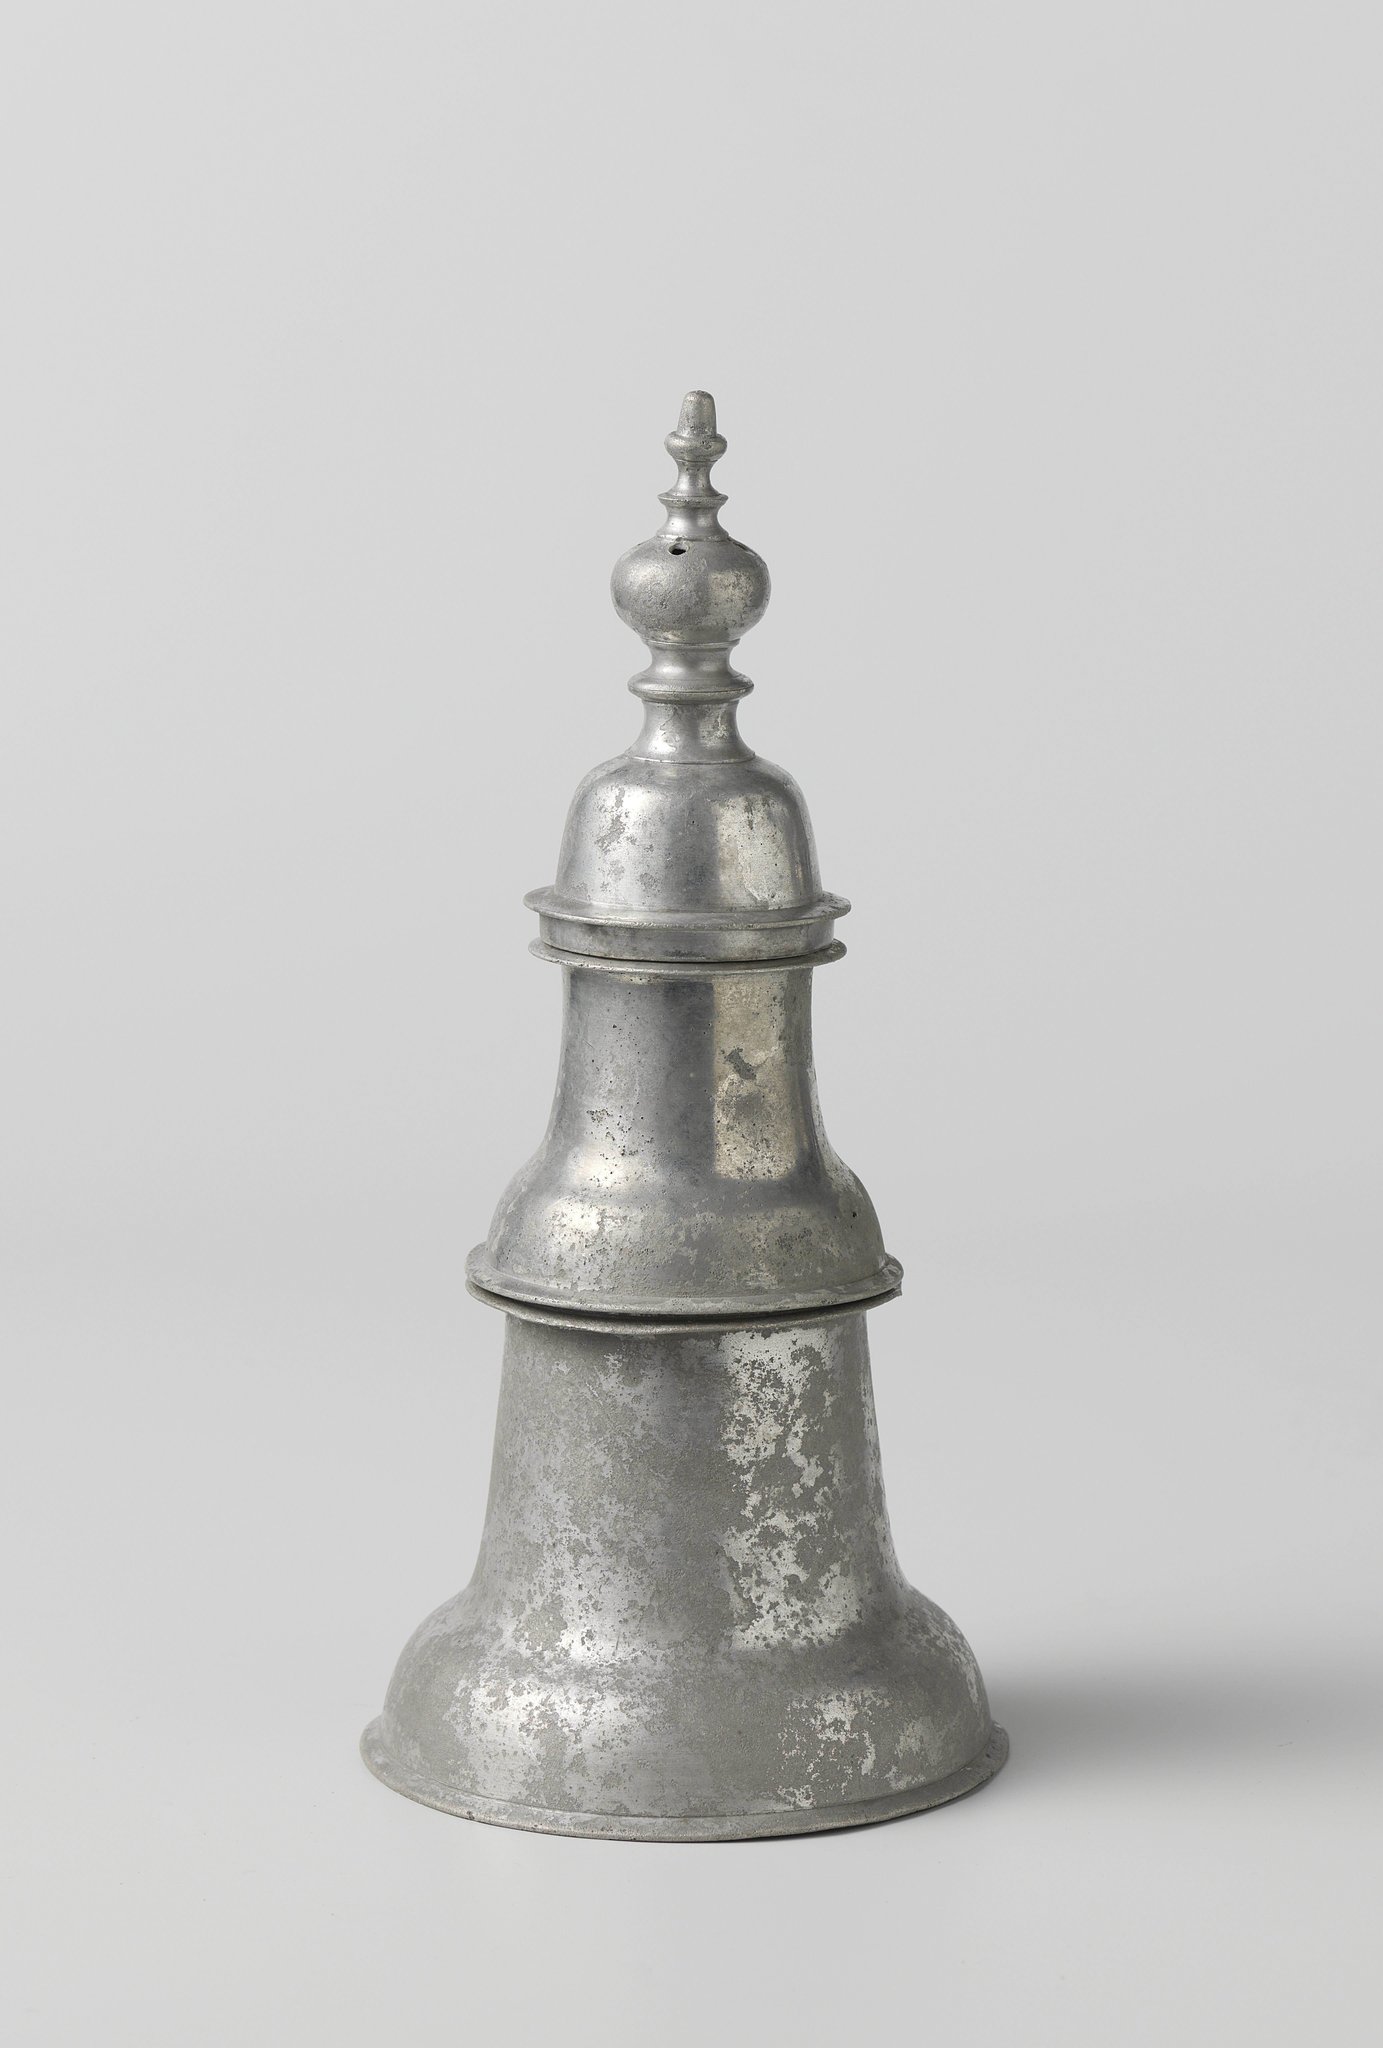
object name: salt condiment vessel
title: Merchandise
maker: Anonymous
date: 1590-1596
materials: tin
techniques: casting, silvering, soldering, turning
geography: england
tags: willem barendsz., amsterdam, jacob van heemskerck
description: Among the merchandise intended for the Asian market were pewter salt-cellars and a splendidly ornamented ewer. The pewter medallions in wooden frames were meant to serve as wall decorations.